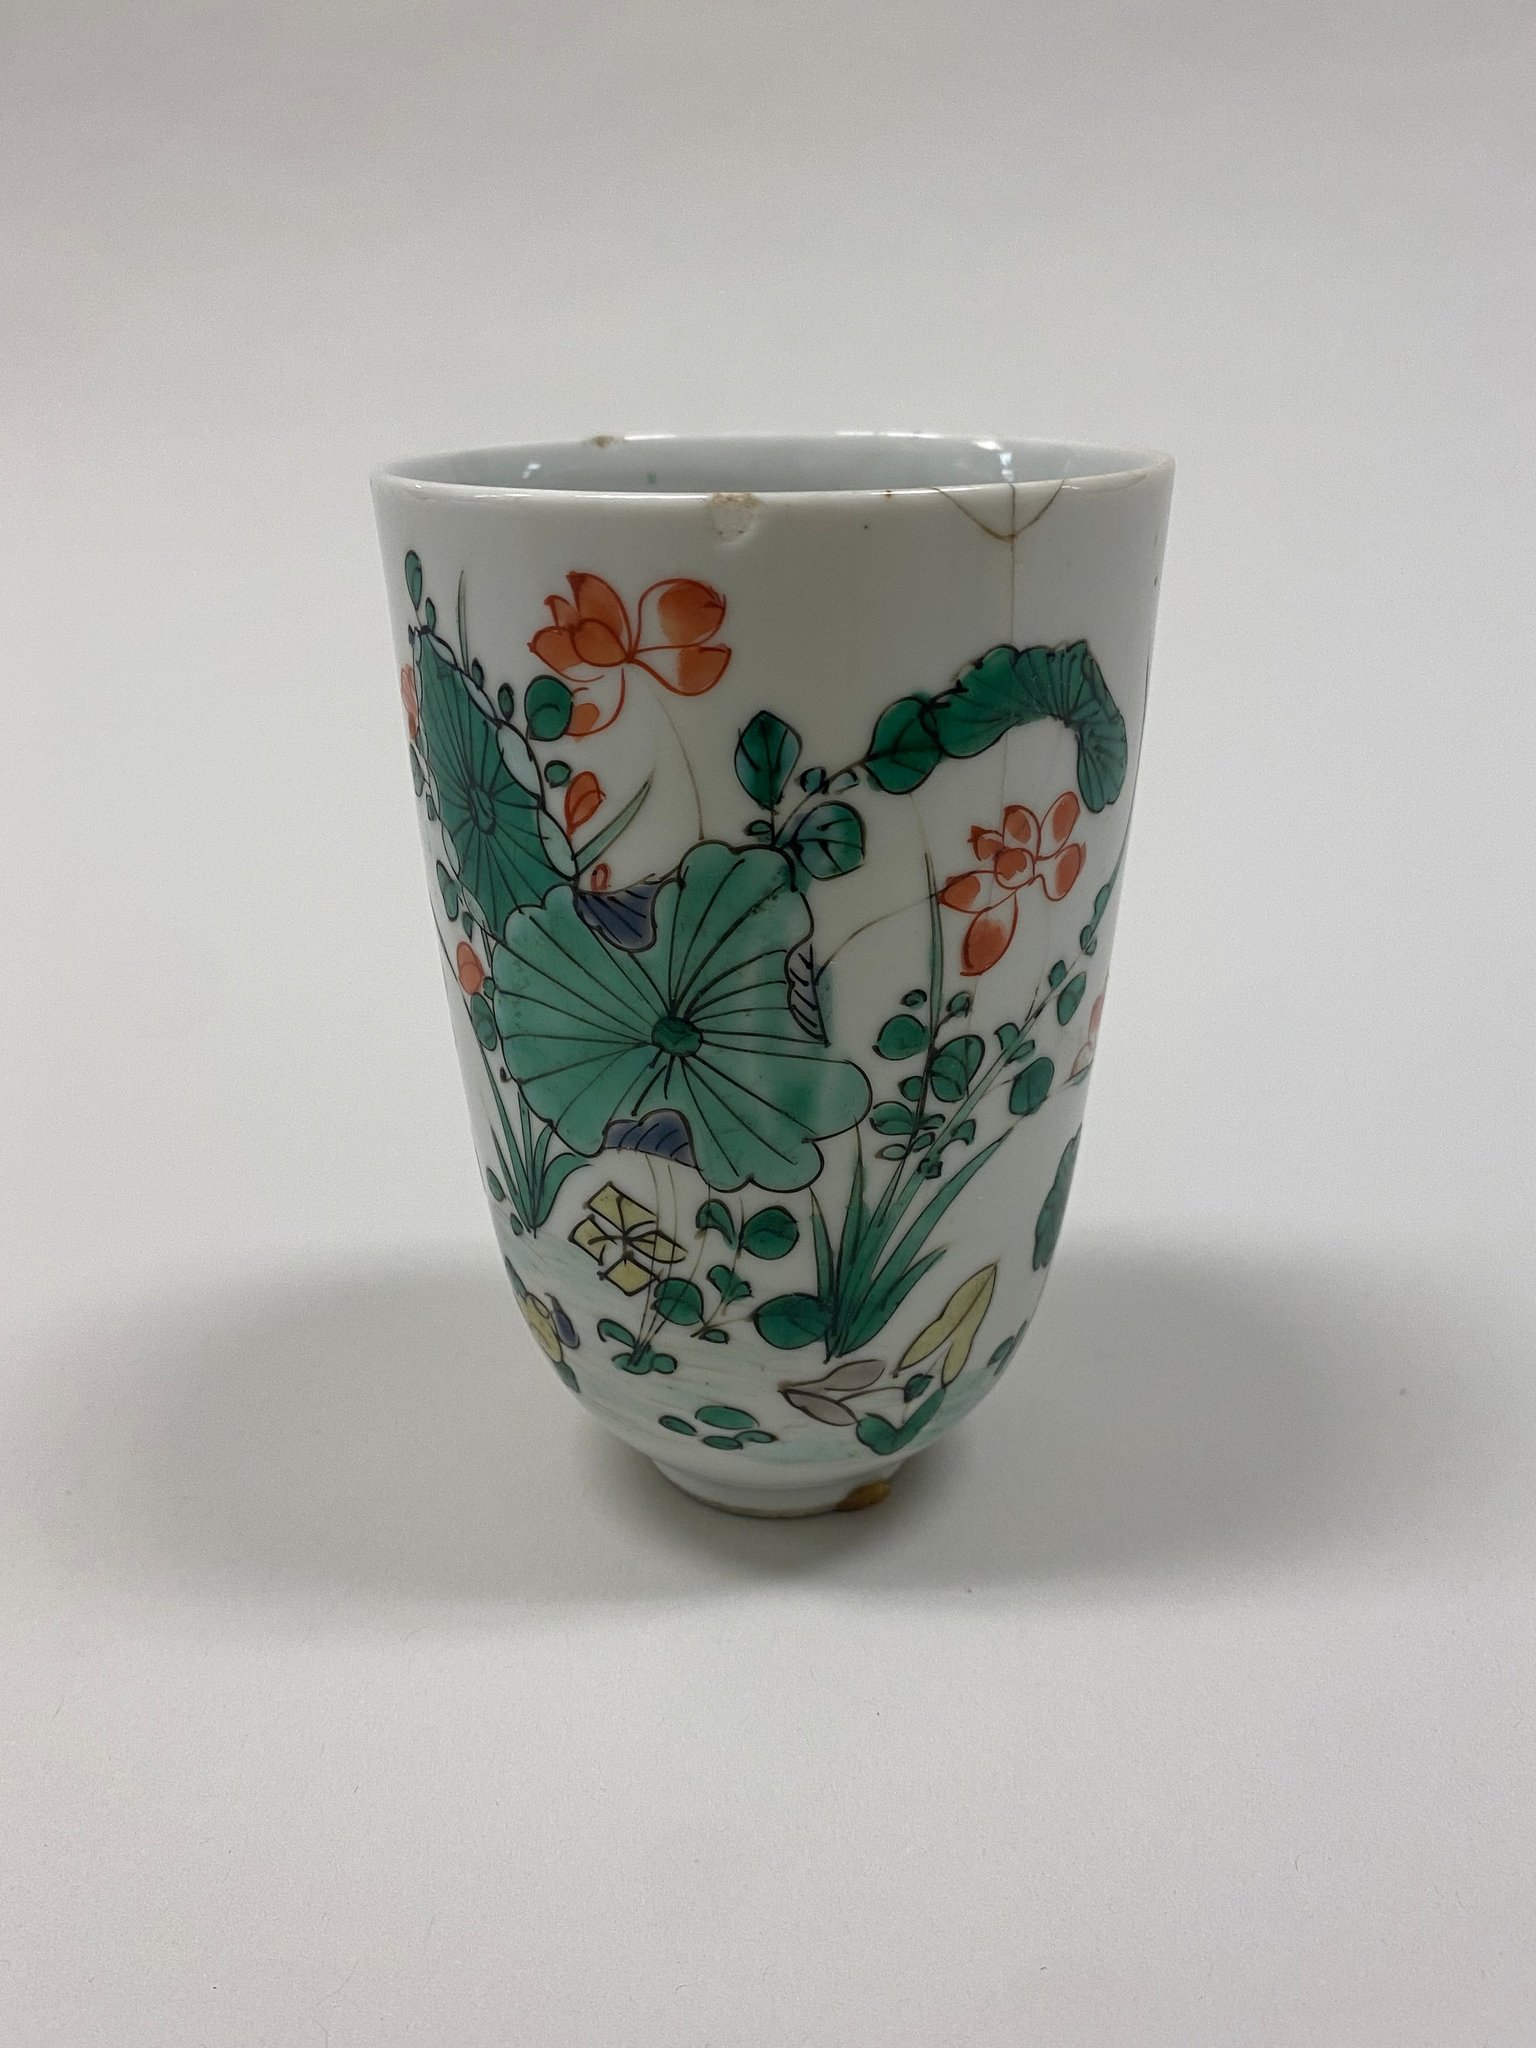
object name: cup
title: Cup with a scene of lotus pond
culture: chinese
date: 1667-1733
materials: enamel, porcelain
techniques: overglaze, painting, polychrome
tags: flowers